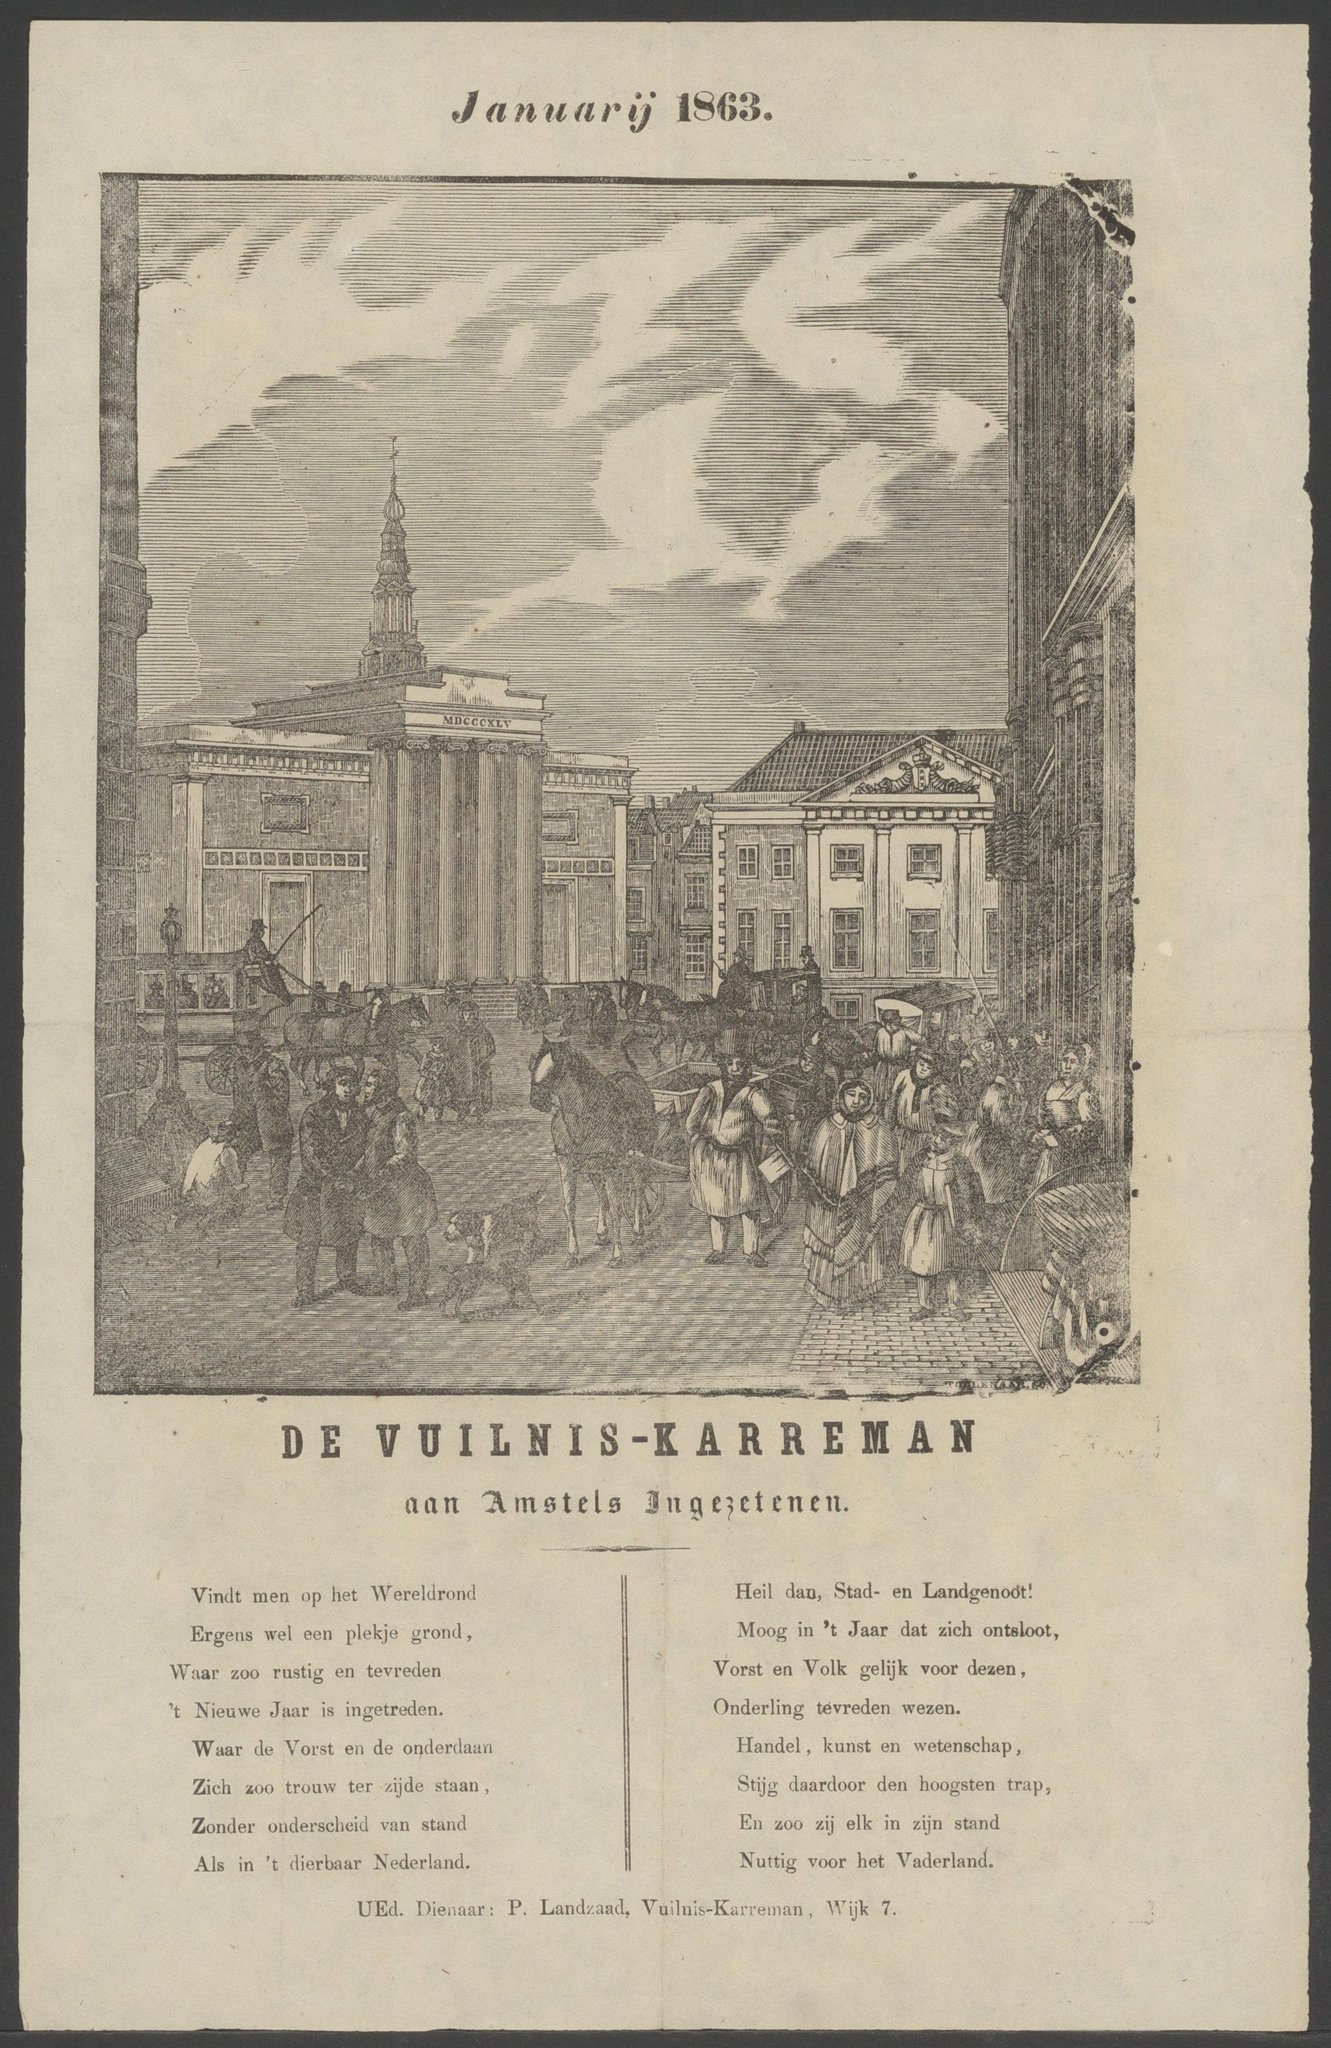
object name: print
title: De Vuilnis-karreman aan Amstels ingezetenen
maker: dirk wijbrand tollenaar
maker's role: print maker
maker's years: 1808-1858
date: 1862-1863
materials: paper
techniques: letterpress printing, engraving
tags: street, garbage collection, amsterdam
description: Nieuwjaarswens van de Amsterdamse vuilnismannen voor het jaar 1863. Gezicht op de Dam met de Beurs van Zocher en het Commandantshuis te Amsterdam. Tussen het publiek de vuilnismannen met hun kar. Met gedicht in twee kolommen. Van de vuilniskarman in de wijk no. 7: P. Landzaad. Onderwerpsrubrieken binnen de Atlas Zeden en Gewoonten: Zeden en gewoonten in engeren zin, Volksleven, Volksbladen, Nieuwjaars- en Kerstwenschen, Amsterdam.